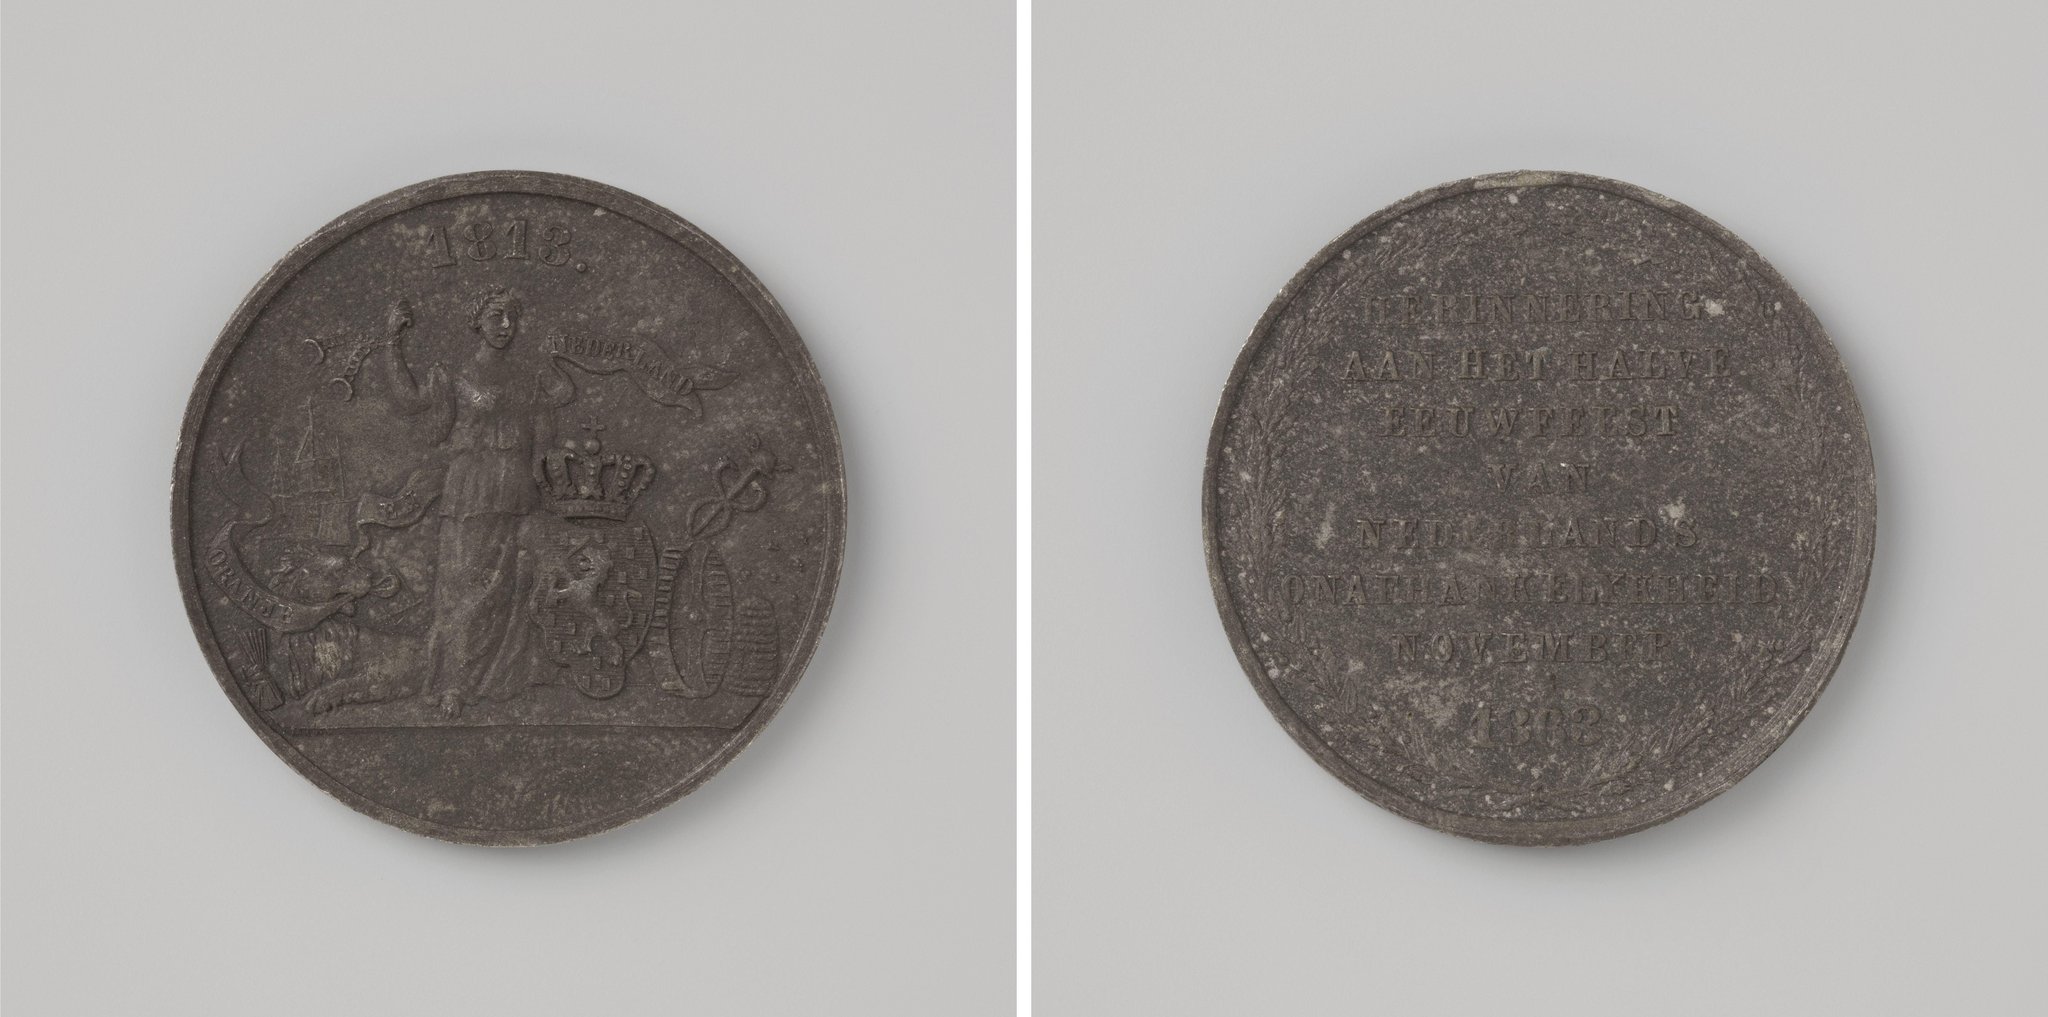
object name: history medal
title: Vijftigjarige onafhankelijkheid van Nederland 1863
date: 1863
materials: tin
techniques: striking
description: Tinnen penning, op de voorzijde de Nederlandse Maagd met verbroken ketens tussen de Nederlandse leeuw met tekstlint en het gekroonde Nederlandse wapenschild, te midden van symbolen van handel en nijverheid, bovenaan het jaartal 1813, op de keerzijde acht regels tekst tussen samengebonden eikentakken.